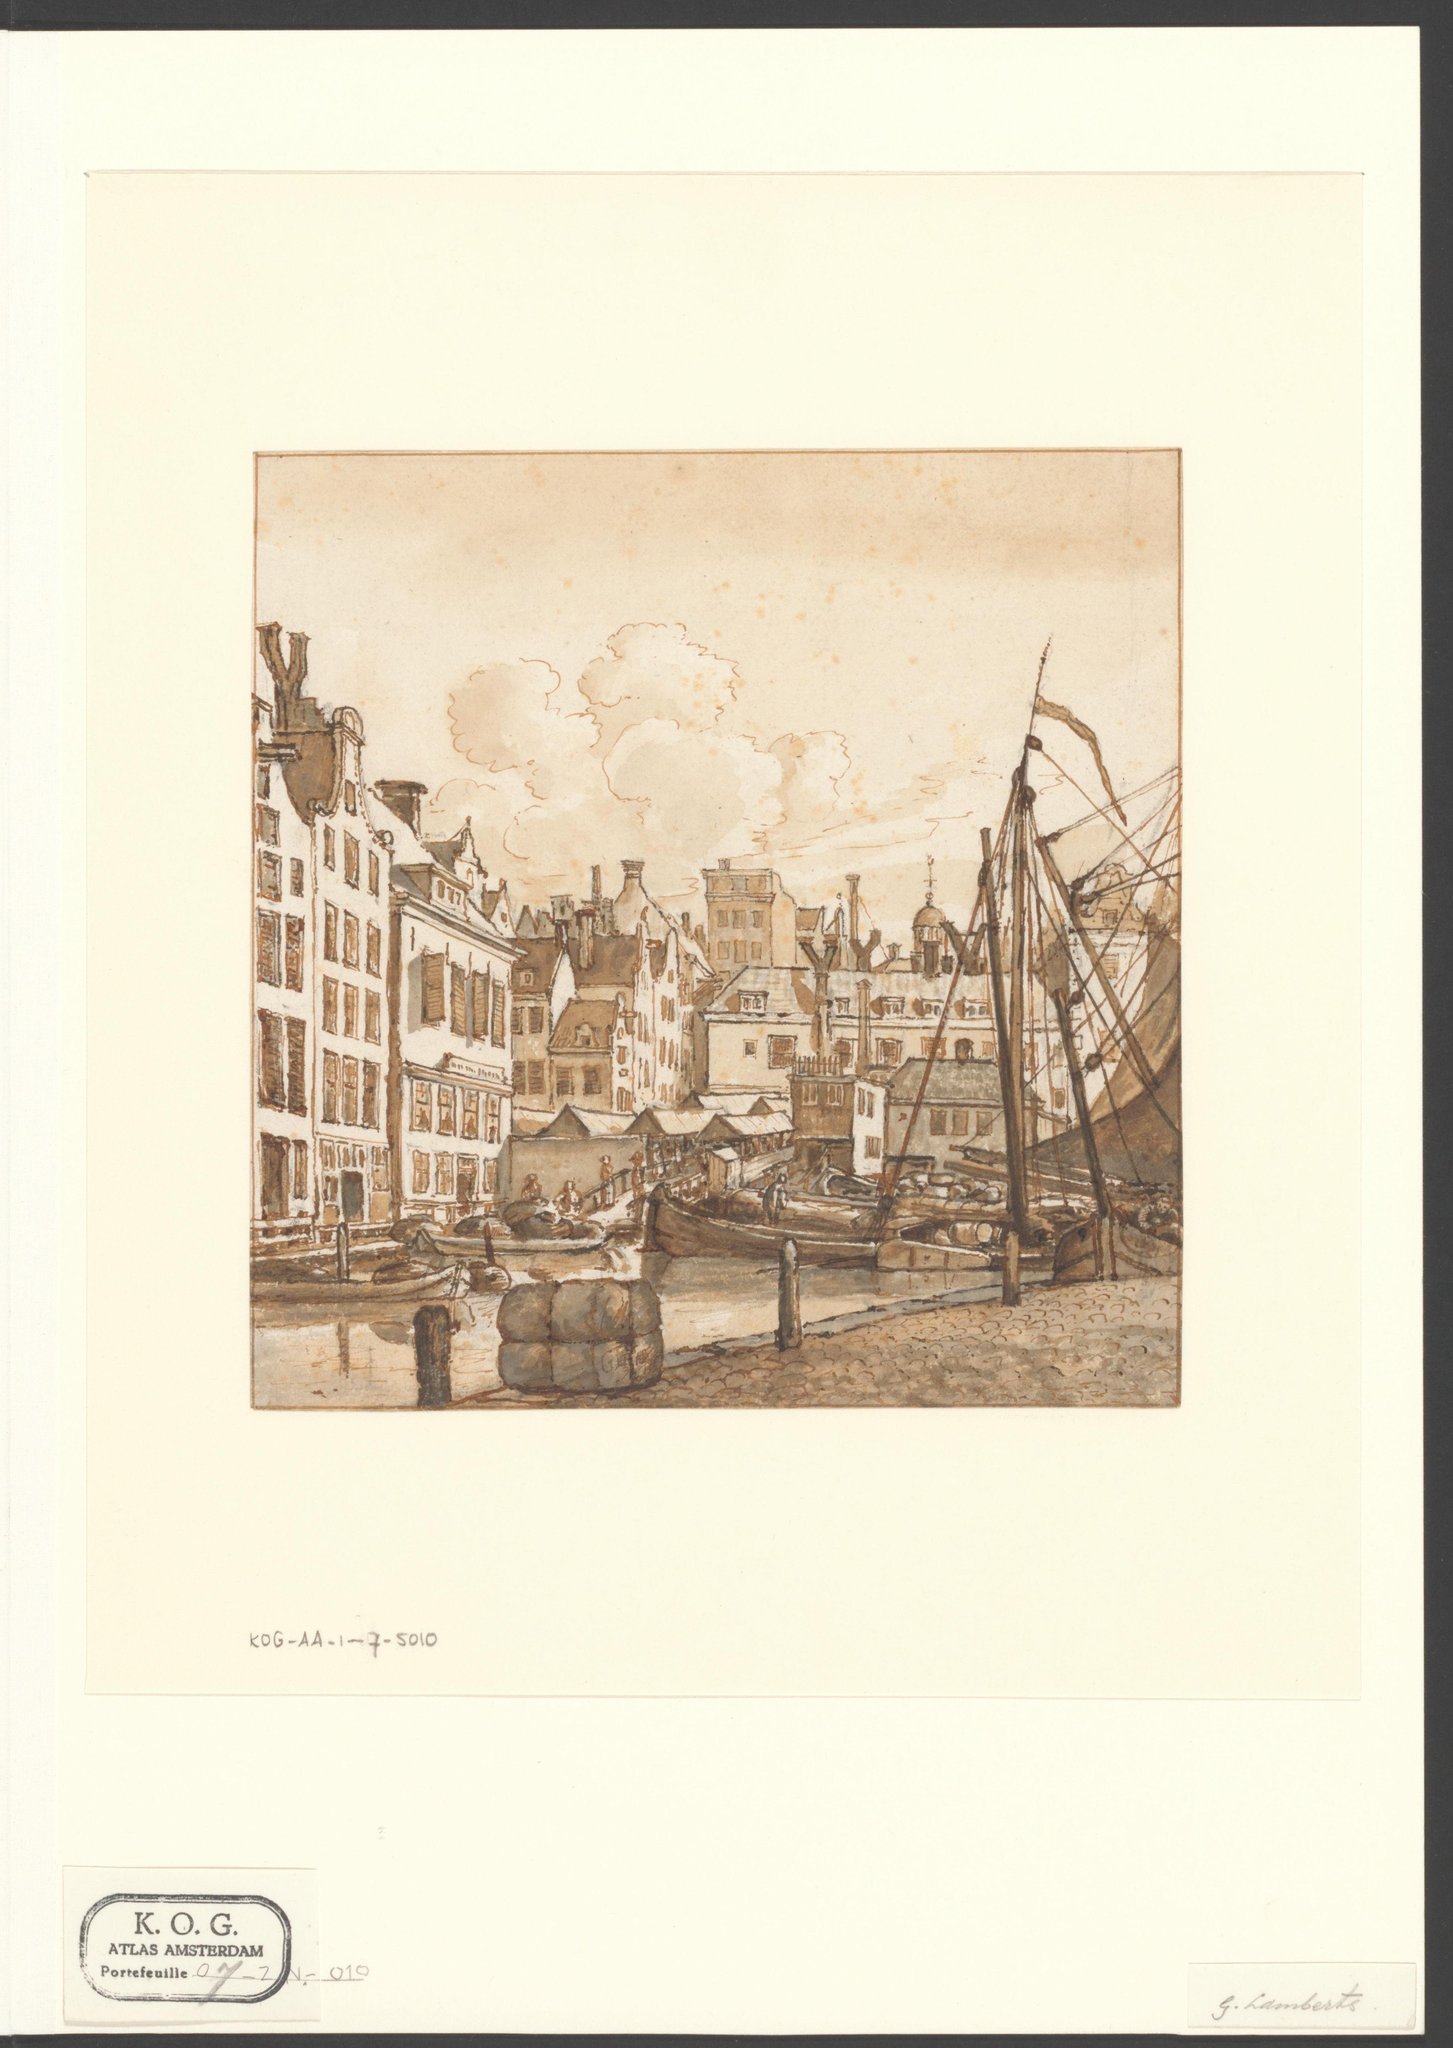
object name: drawing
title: Gezicht op de vismarkt aan het Damrak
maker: gerrit lamberts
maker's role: bookseller, draughtsman, print maker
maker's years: 1776-1850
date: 1816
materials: ink, paper, pencil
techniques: brush, pen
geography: amsterdam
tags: sailing-ship, sailing-boat, city-view in general; 'veduta', canal, market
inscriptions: collector's mark: ‘07’ Lugt 1641b, signature, date and inscription: ‘De Groote Vischmarkt / van het water of Damrak / te zien / G. Lamberts. 1816.’, inscription: ‘Port. 7’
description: Onderwerpsrubriek binnen de Atlas Amsterdam: Damrak, Damstraat, Doelensluis, Doelenstraat (Nieuwe), Driehoekstraat, Droogbak, Duvelshoek, Dijkstraat en Korte -.